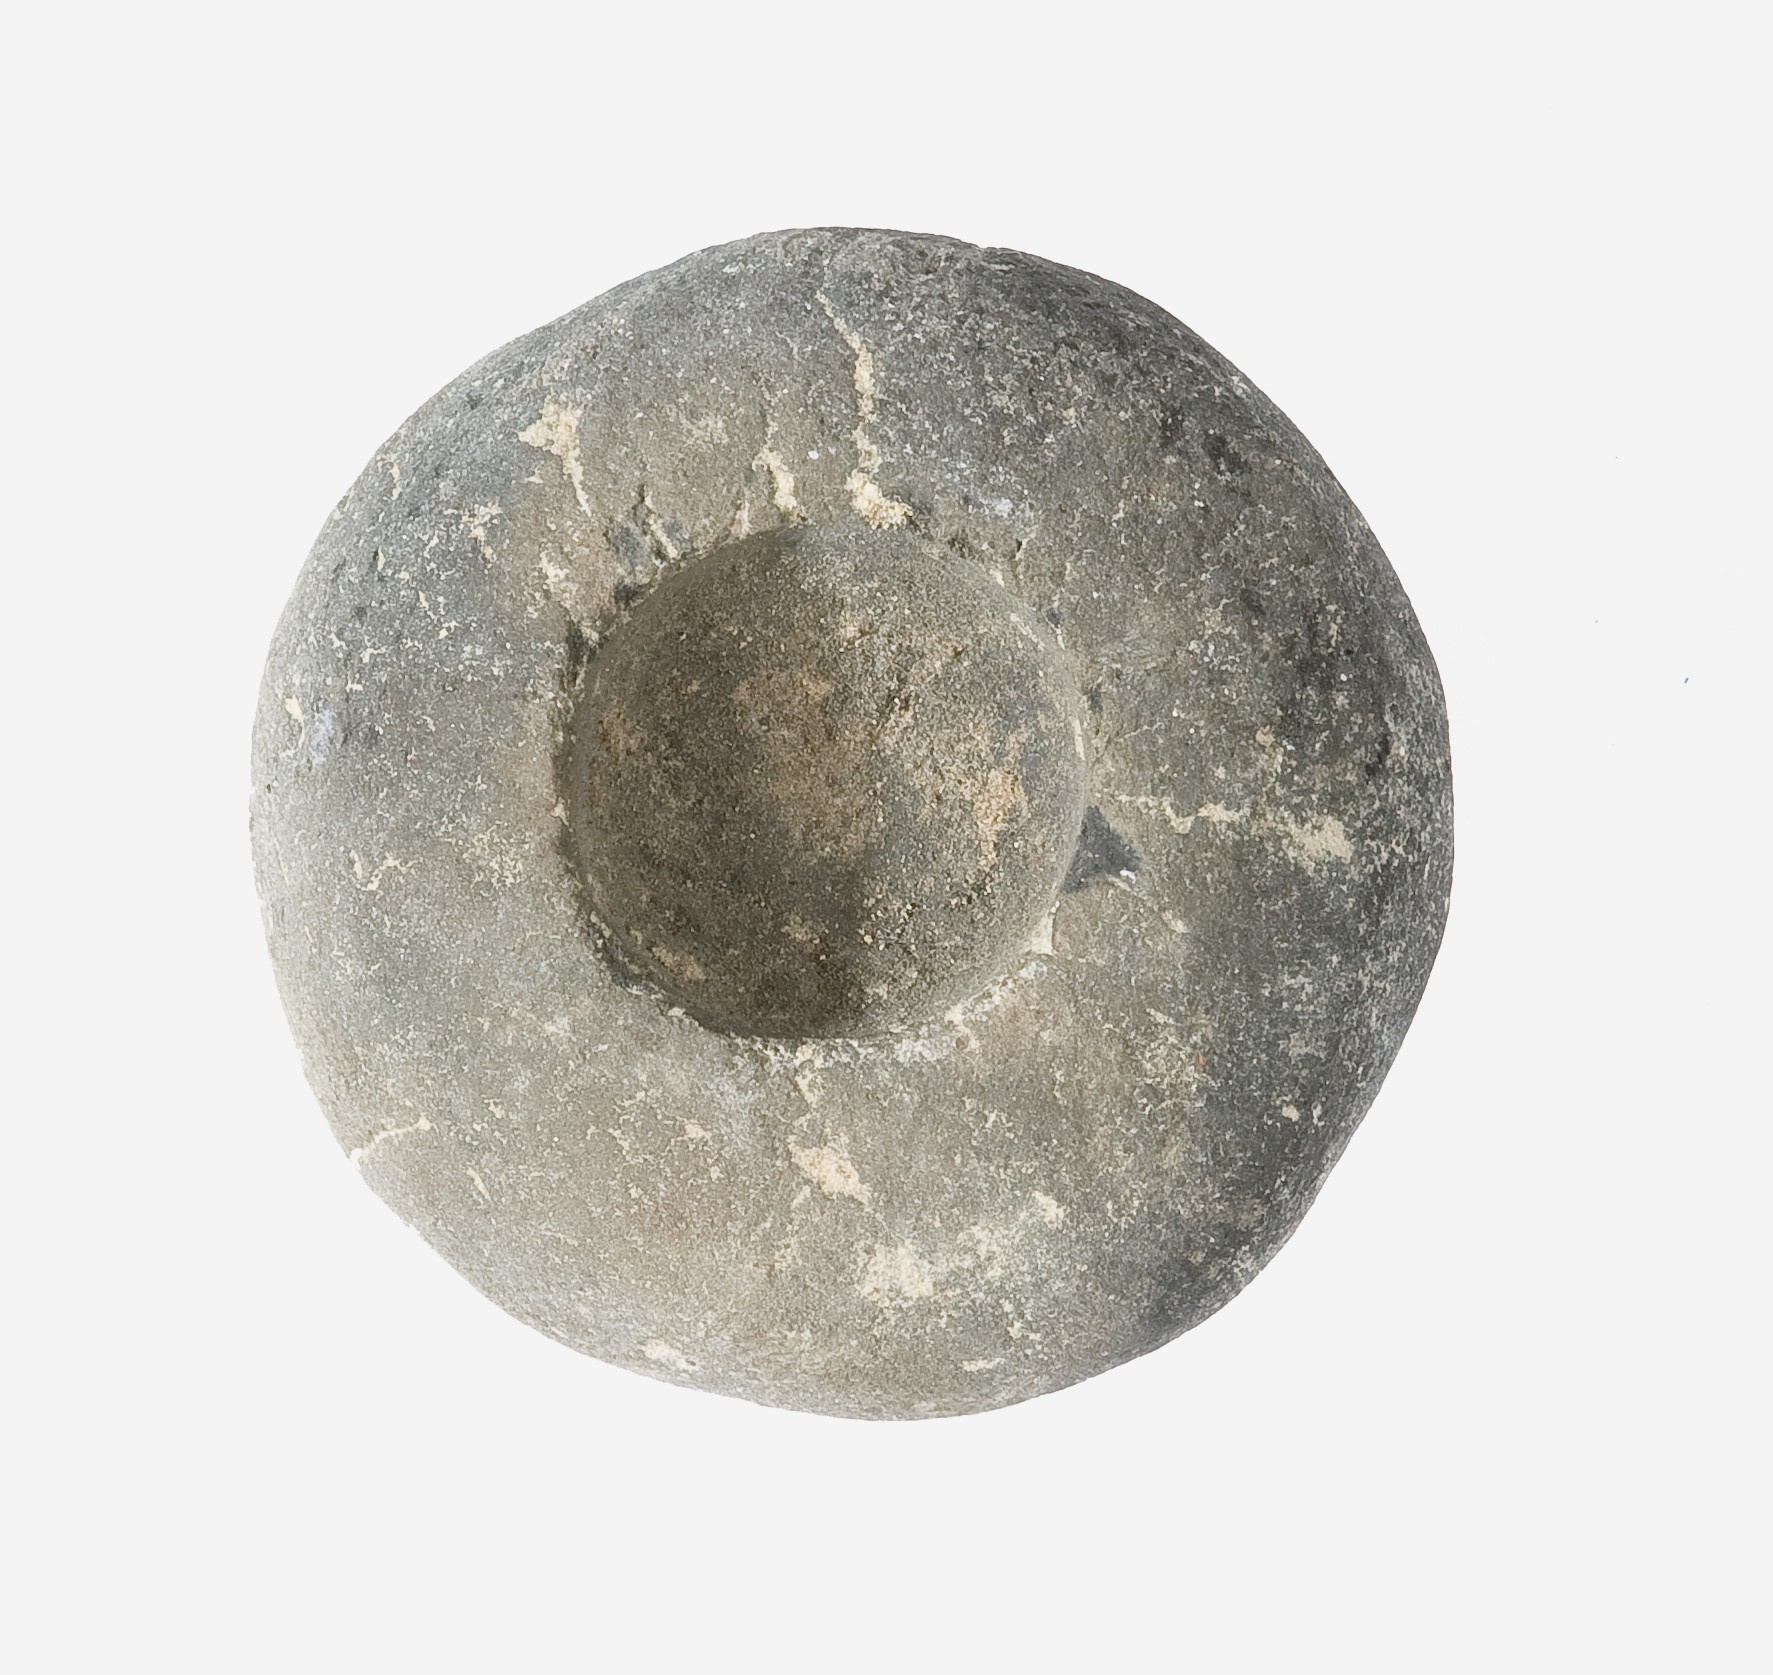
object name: mold, hemisphere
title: Mold for a Hemispherical Boss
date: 1390-1352 BCE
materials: pottery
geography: egypt